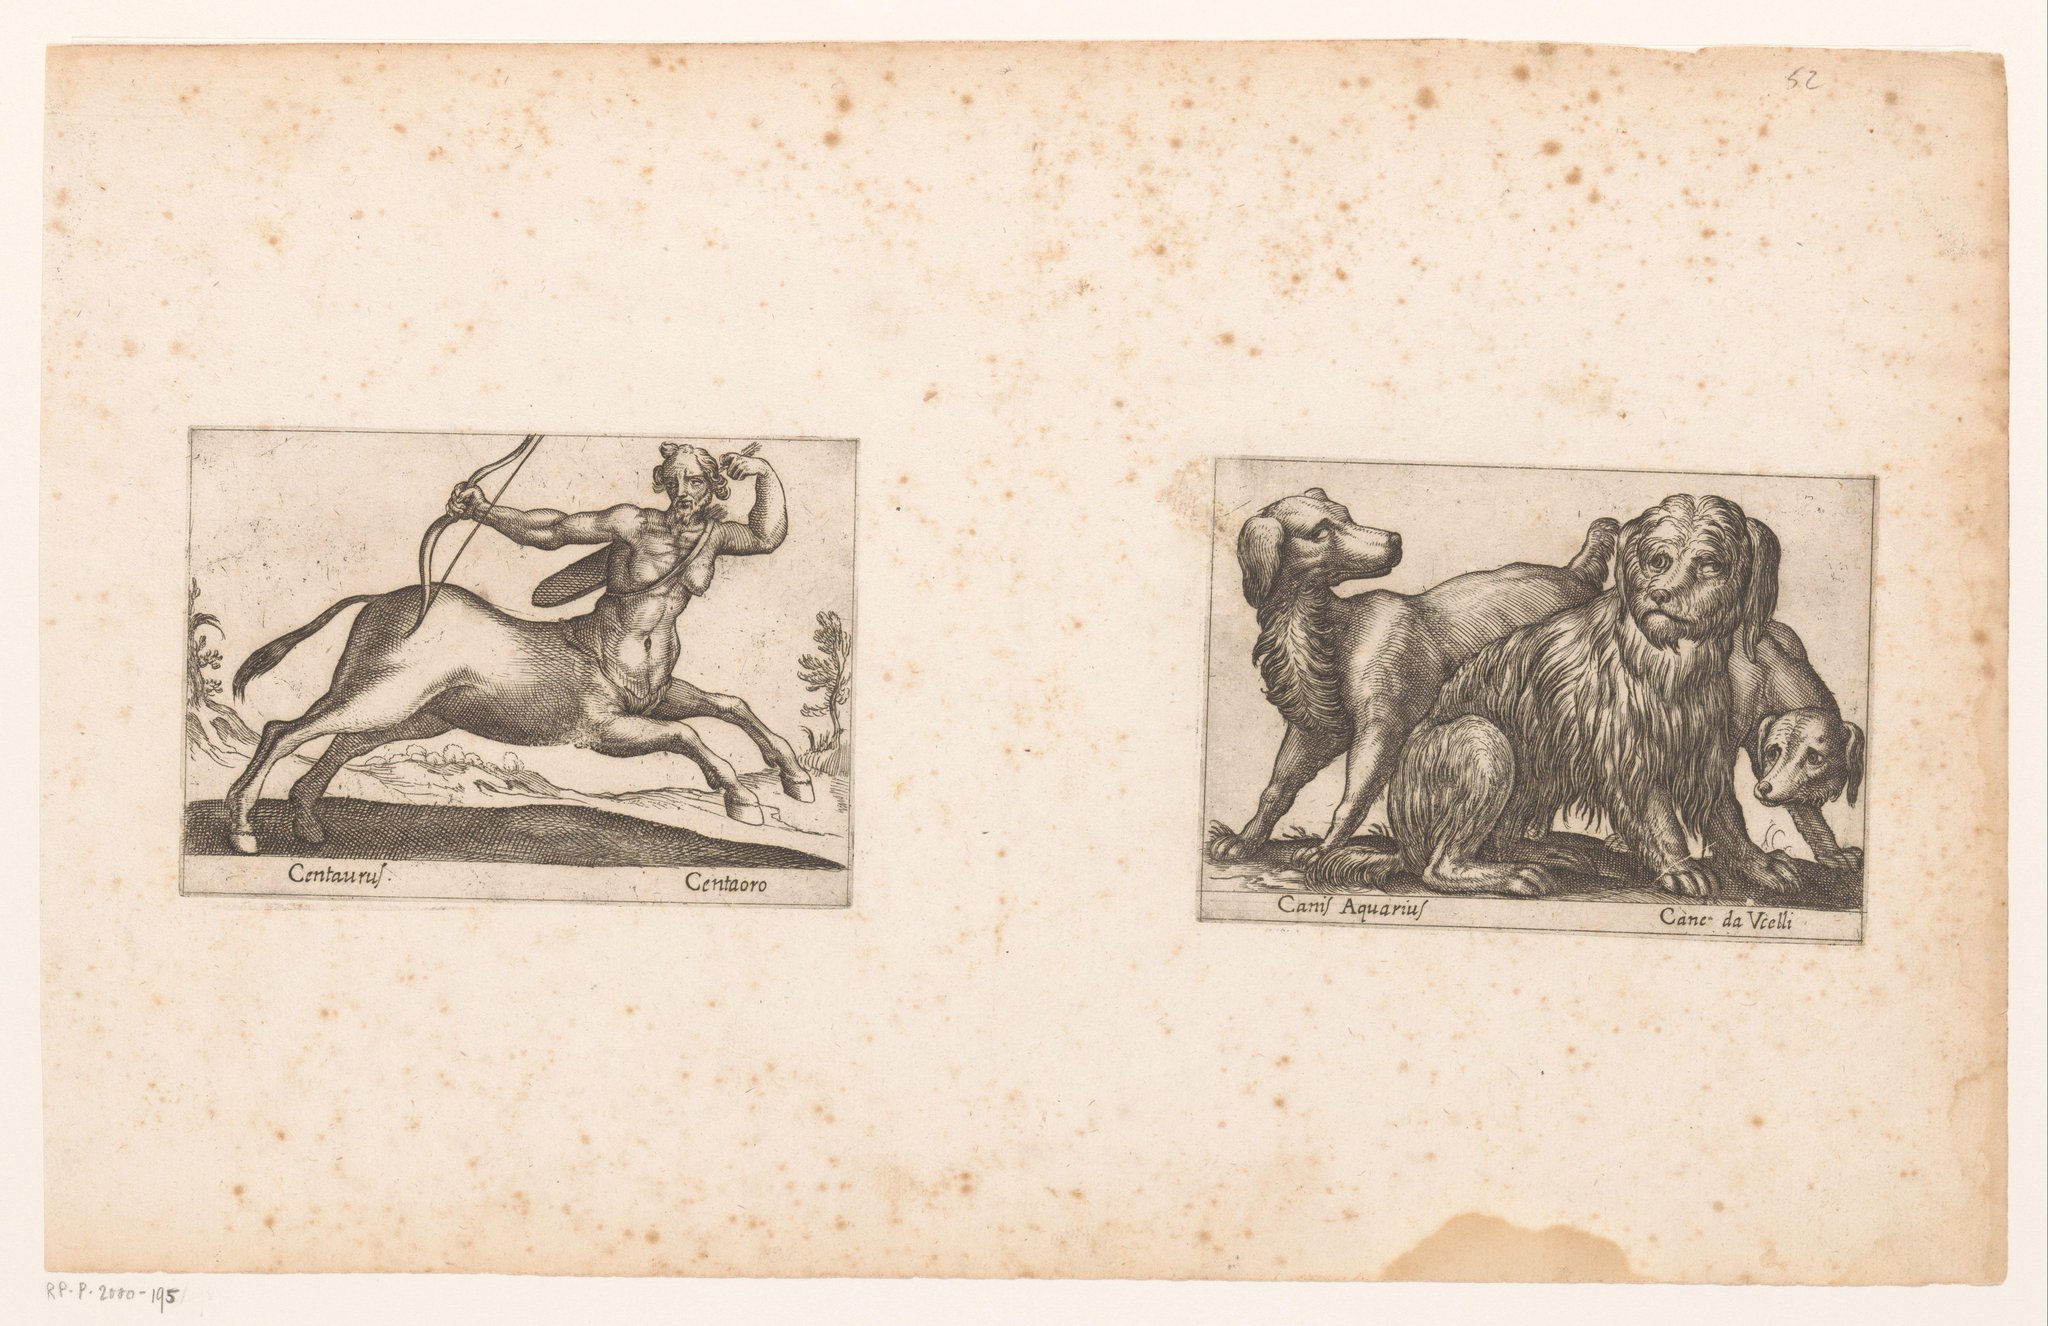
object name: print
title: Dieren en fabelwezens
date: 1575-1630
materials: paper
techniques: etching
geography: vatican city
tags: centaurs, dog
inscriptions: collector's mark: Lugt 2228, collector's mark: Lugt 2760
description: Deze prent maakt deel uit van een reeks prenten van dieren door Antonio Tempesta. Bekend is dat een tweede staat (met nummering) van deze serie is uitgegeven door Giovanni Giacomo de' Rossi in 1650. Onbekend is wie de eerste staat heeft uitgegeven en wanneer.